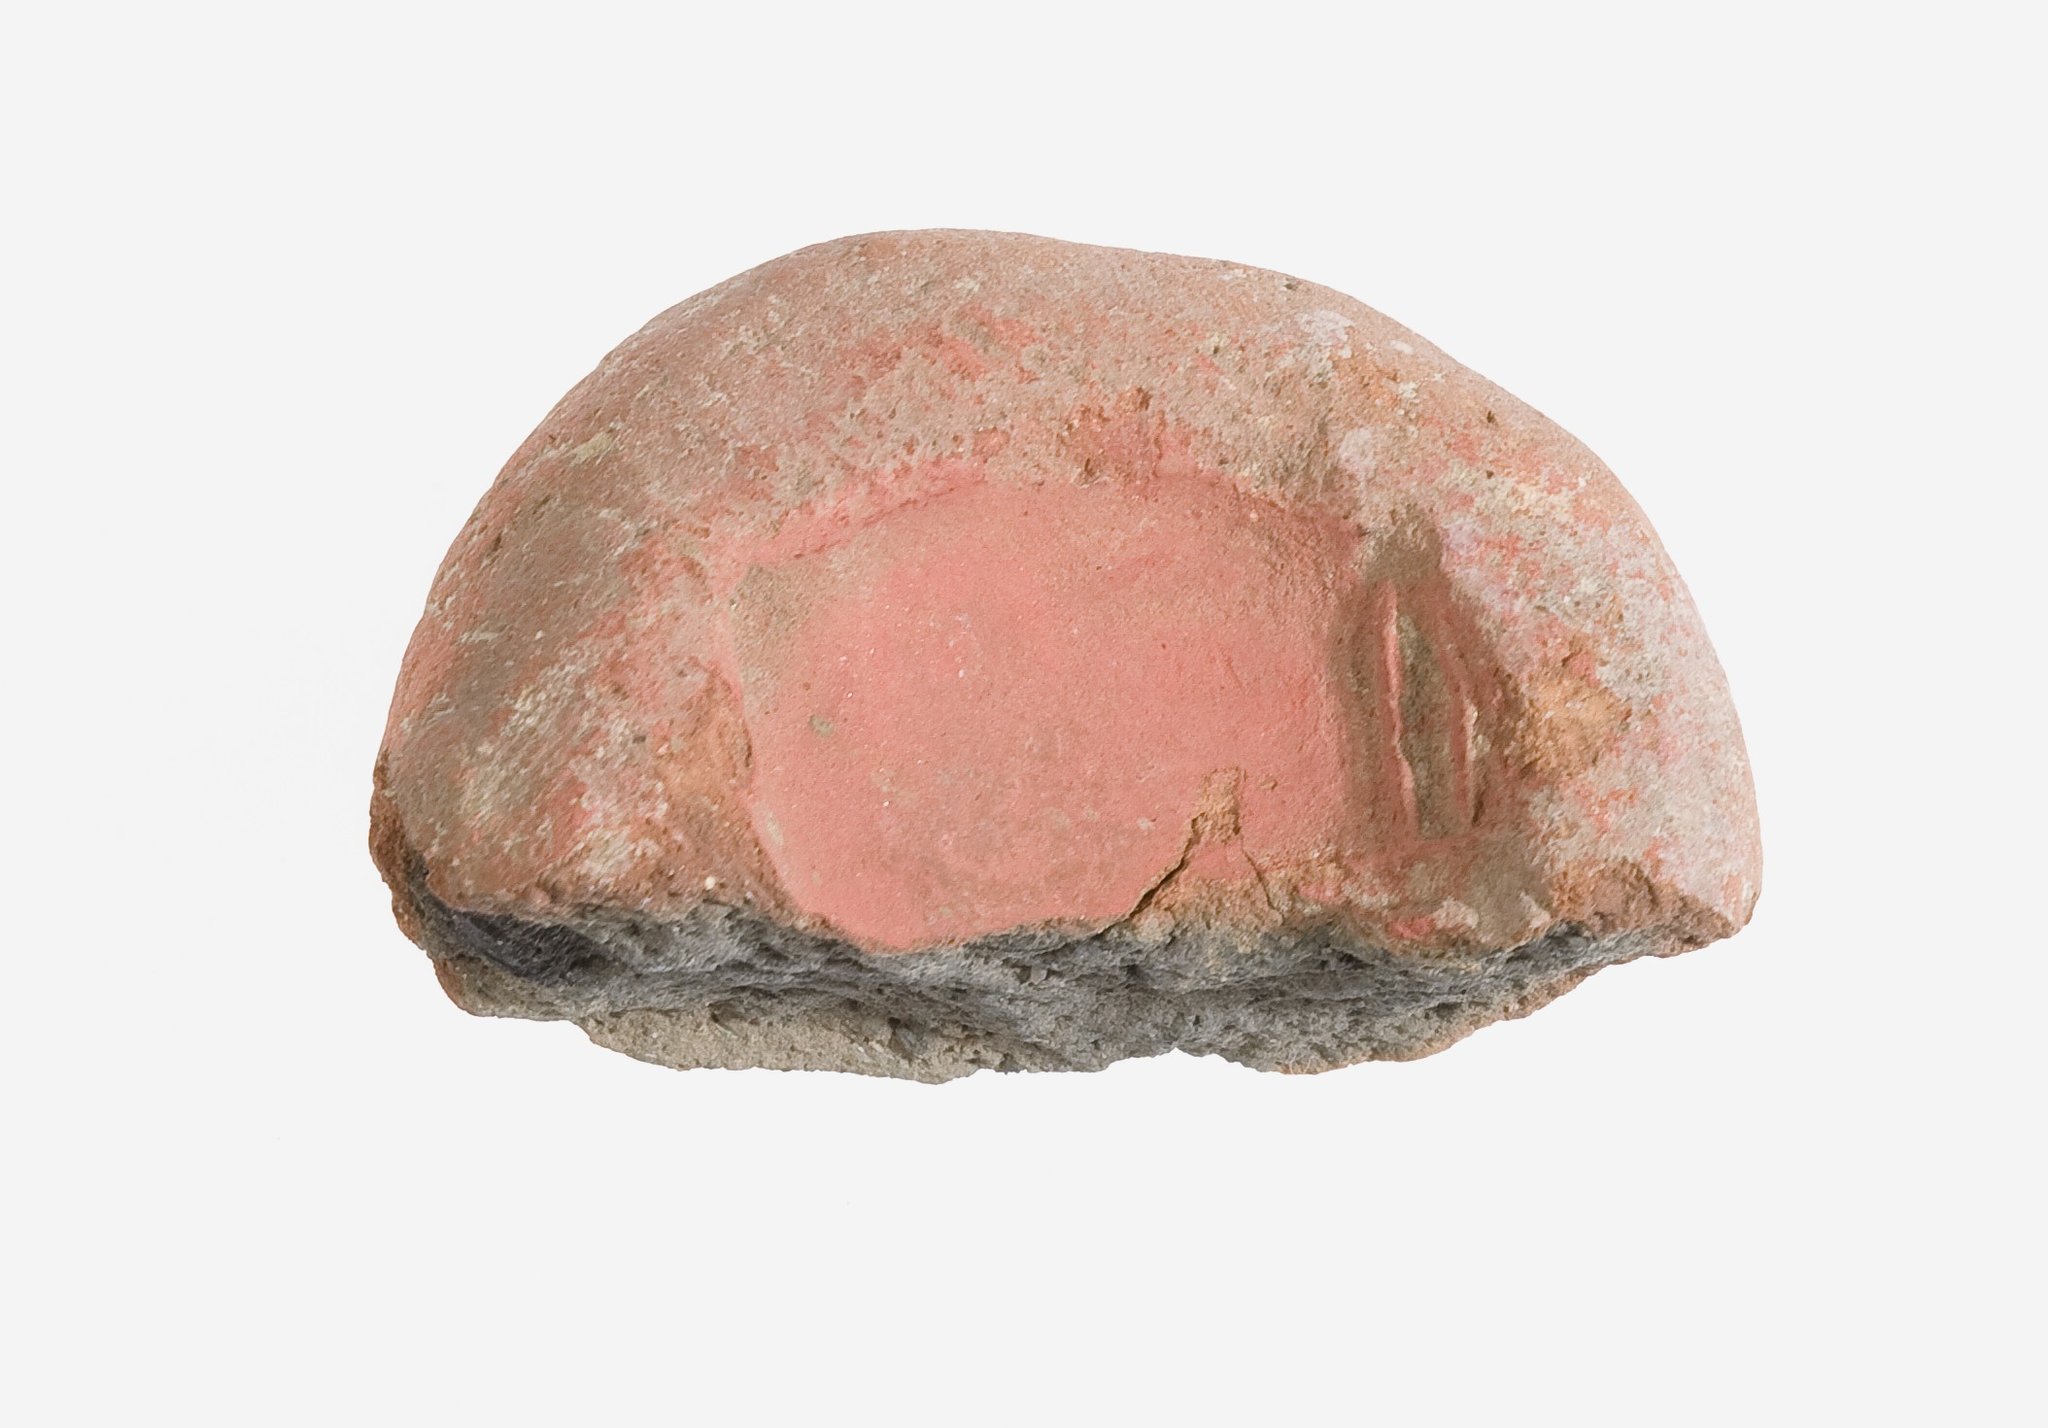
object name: mold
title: Persia Fruit Mold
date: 1390-1352 BCE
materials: pottery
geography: egypt